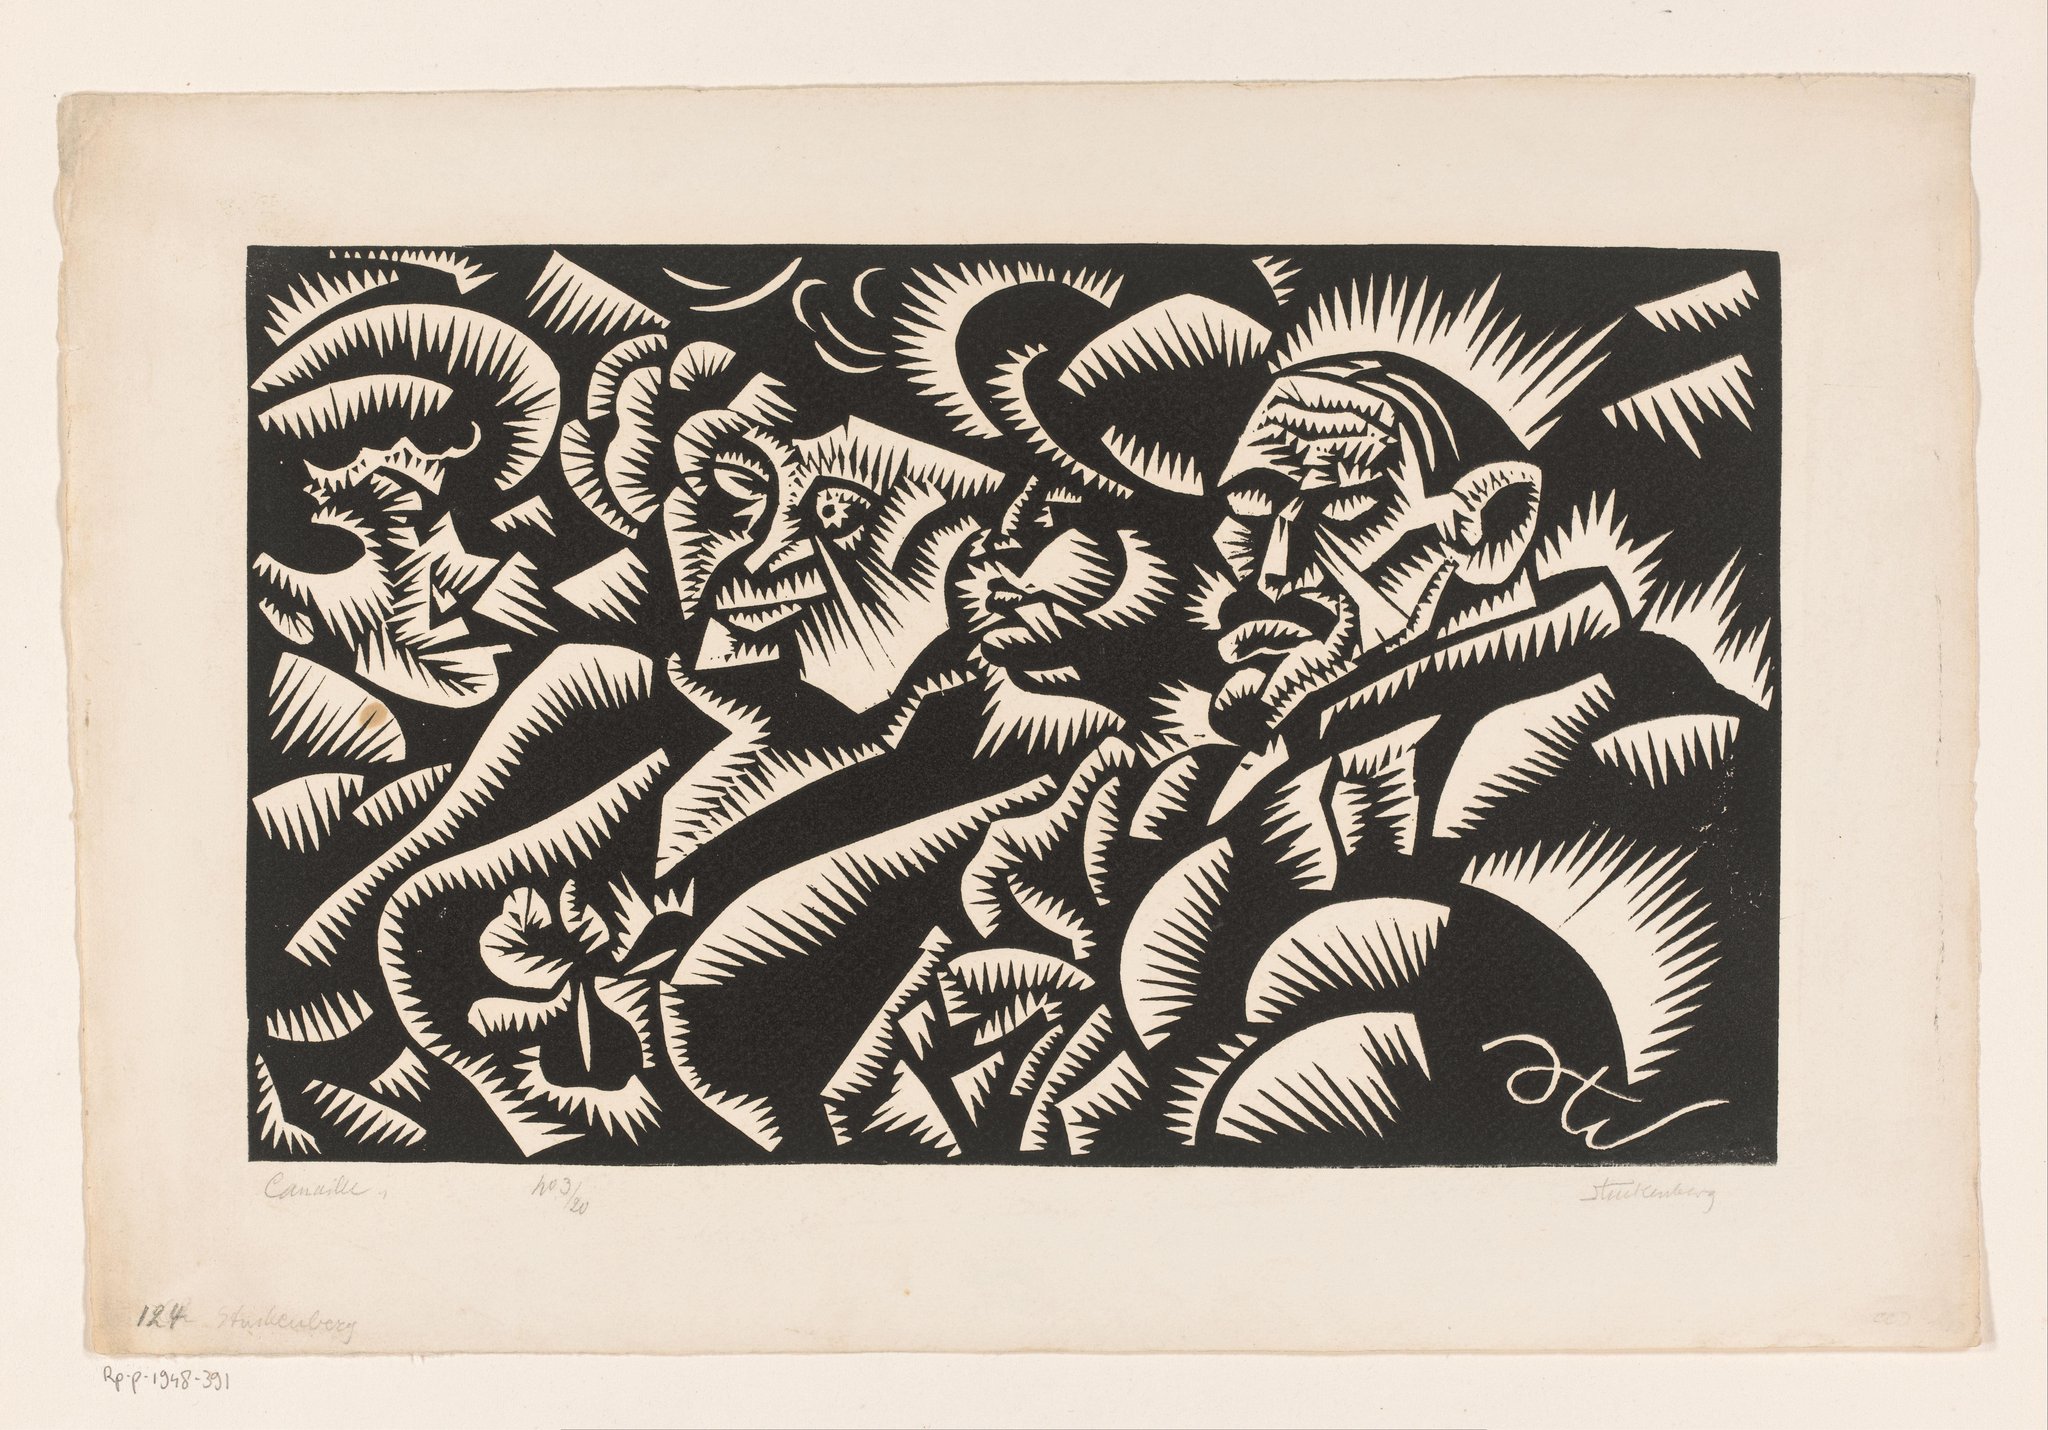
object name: print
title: Canaille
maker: fritz stuckenberg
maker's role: print maker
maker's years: 1881-1944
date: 1891-1944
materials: paper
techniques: woodcut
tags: the (nude) human figure; 'corpo humano' (ripa)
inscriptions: collector's mark: Lugt 2228